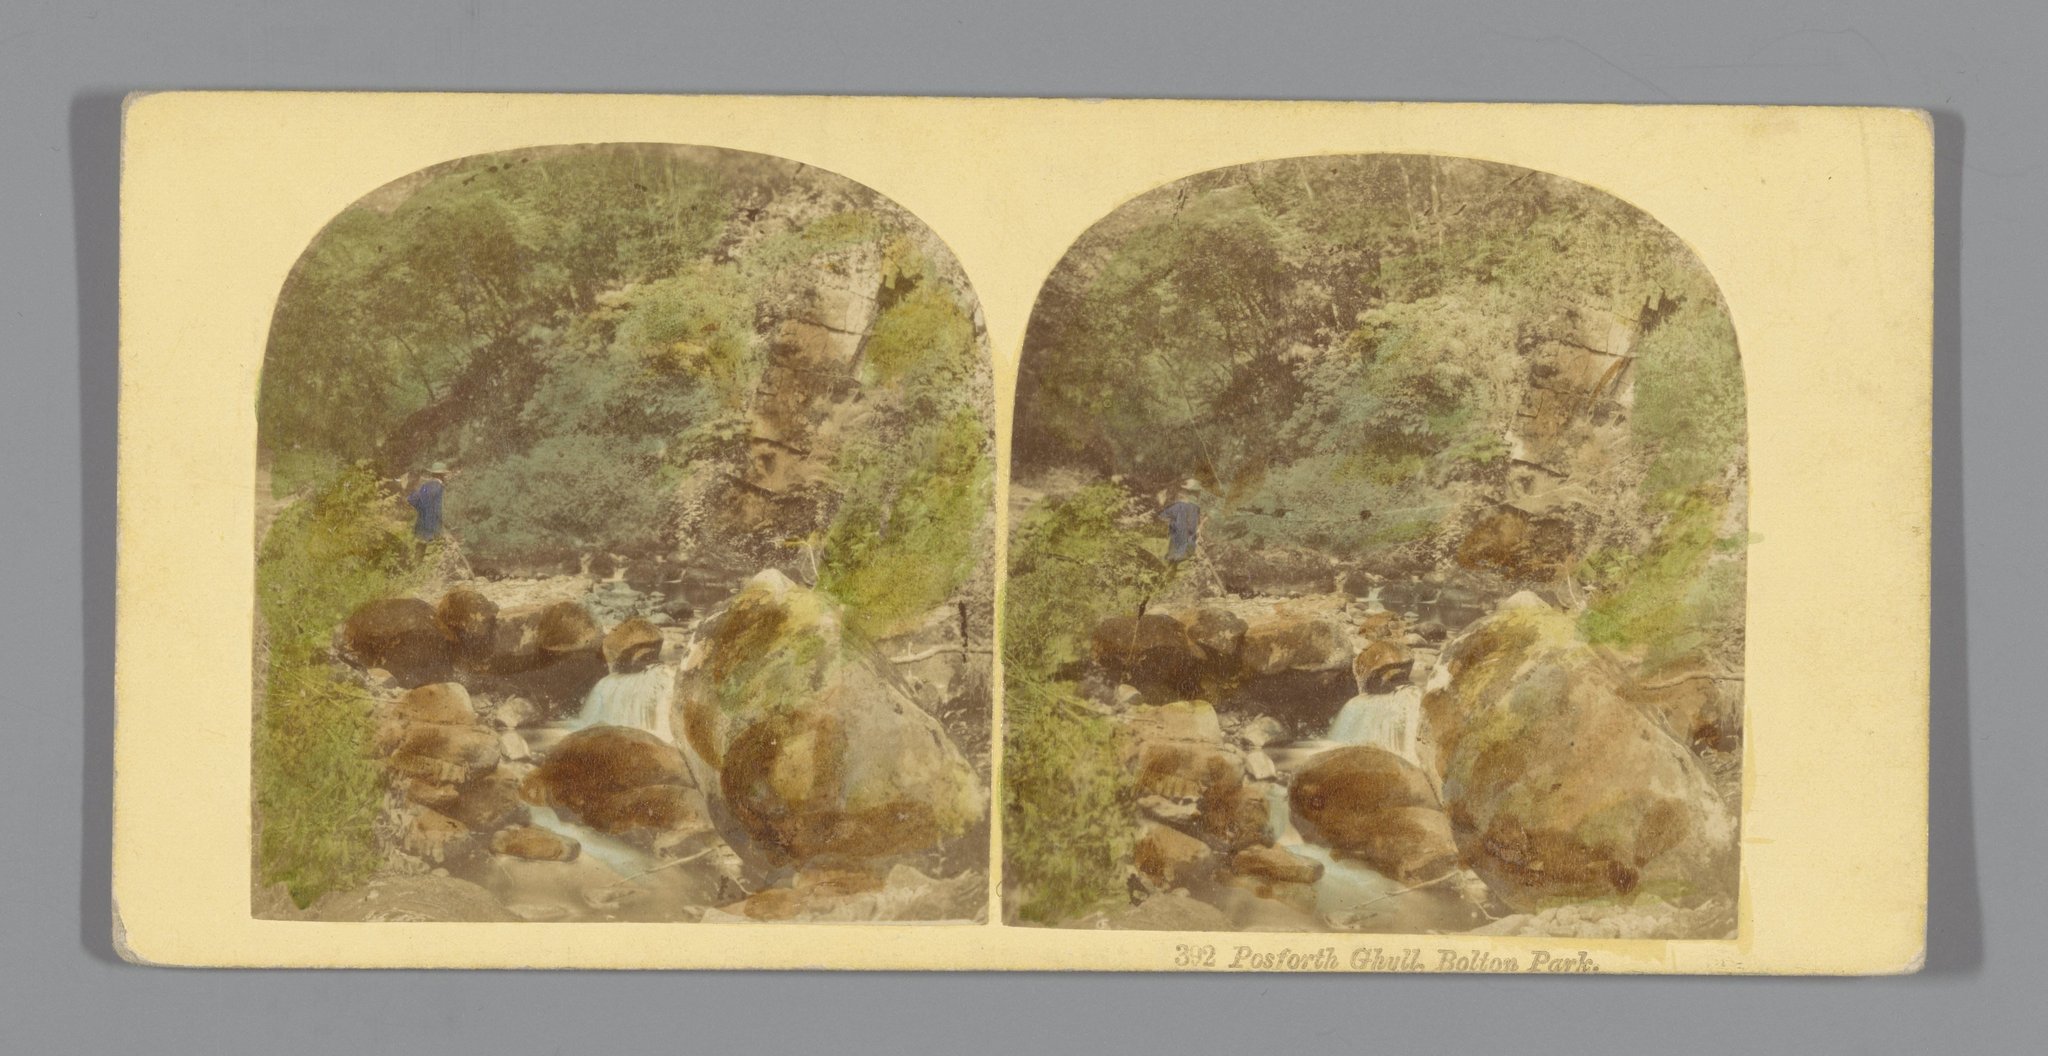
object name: stereograph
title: Posforth Ghyll, Bolton Park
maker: Anonymous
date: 1850-1880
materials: cardboard, photographic support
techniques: albumen print, hand coloring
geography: wharfedale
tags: waterfall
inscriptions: number: ‘392’, name, number: ‘No. 26’